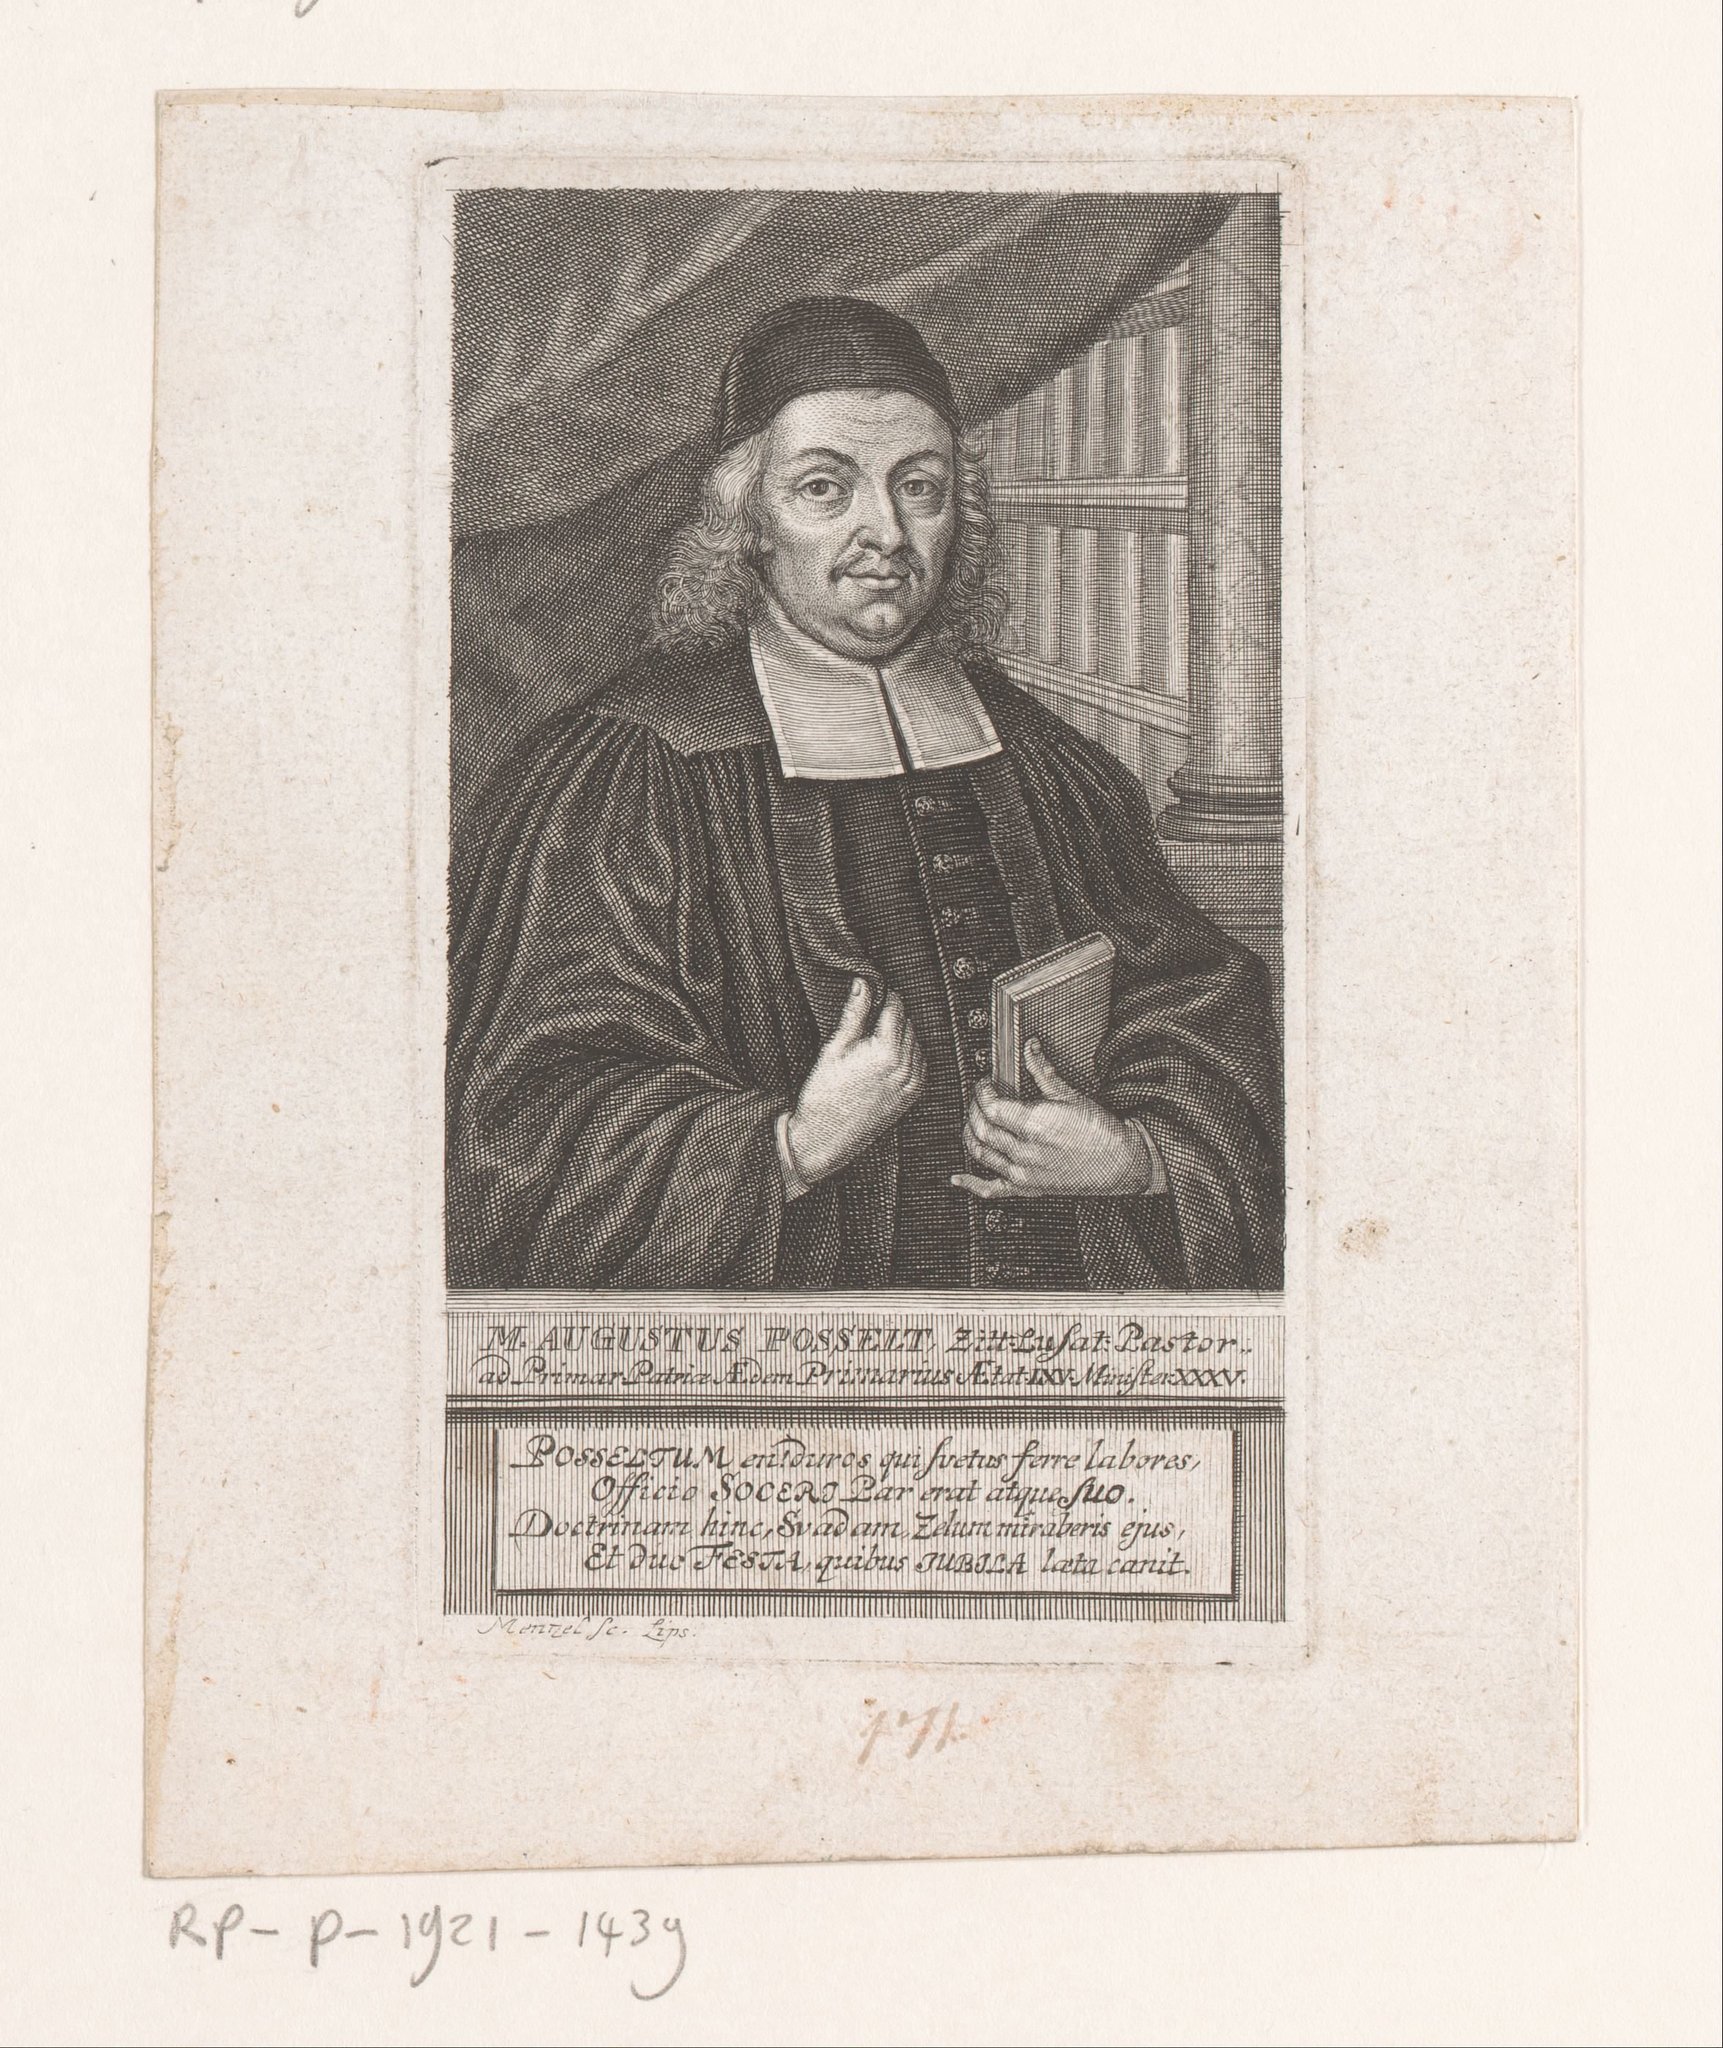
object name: print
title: Portret van August Posselt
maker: johann georg mentzel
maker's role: print maker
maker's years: 1677-1743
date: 1687-1743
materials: paper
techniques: engraving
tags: bookshelves, theologian, historical persons, book, wig, capital (~ column, pillar)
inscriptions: collector's mark: Lugt 2228